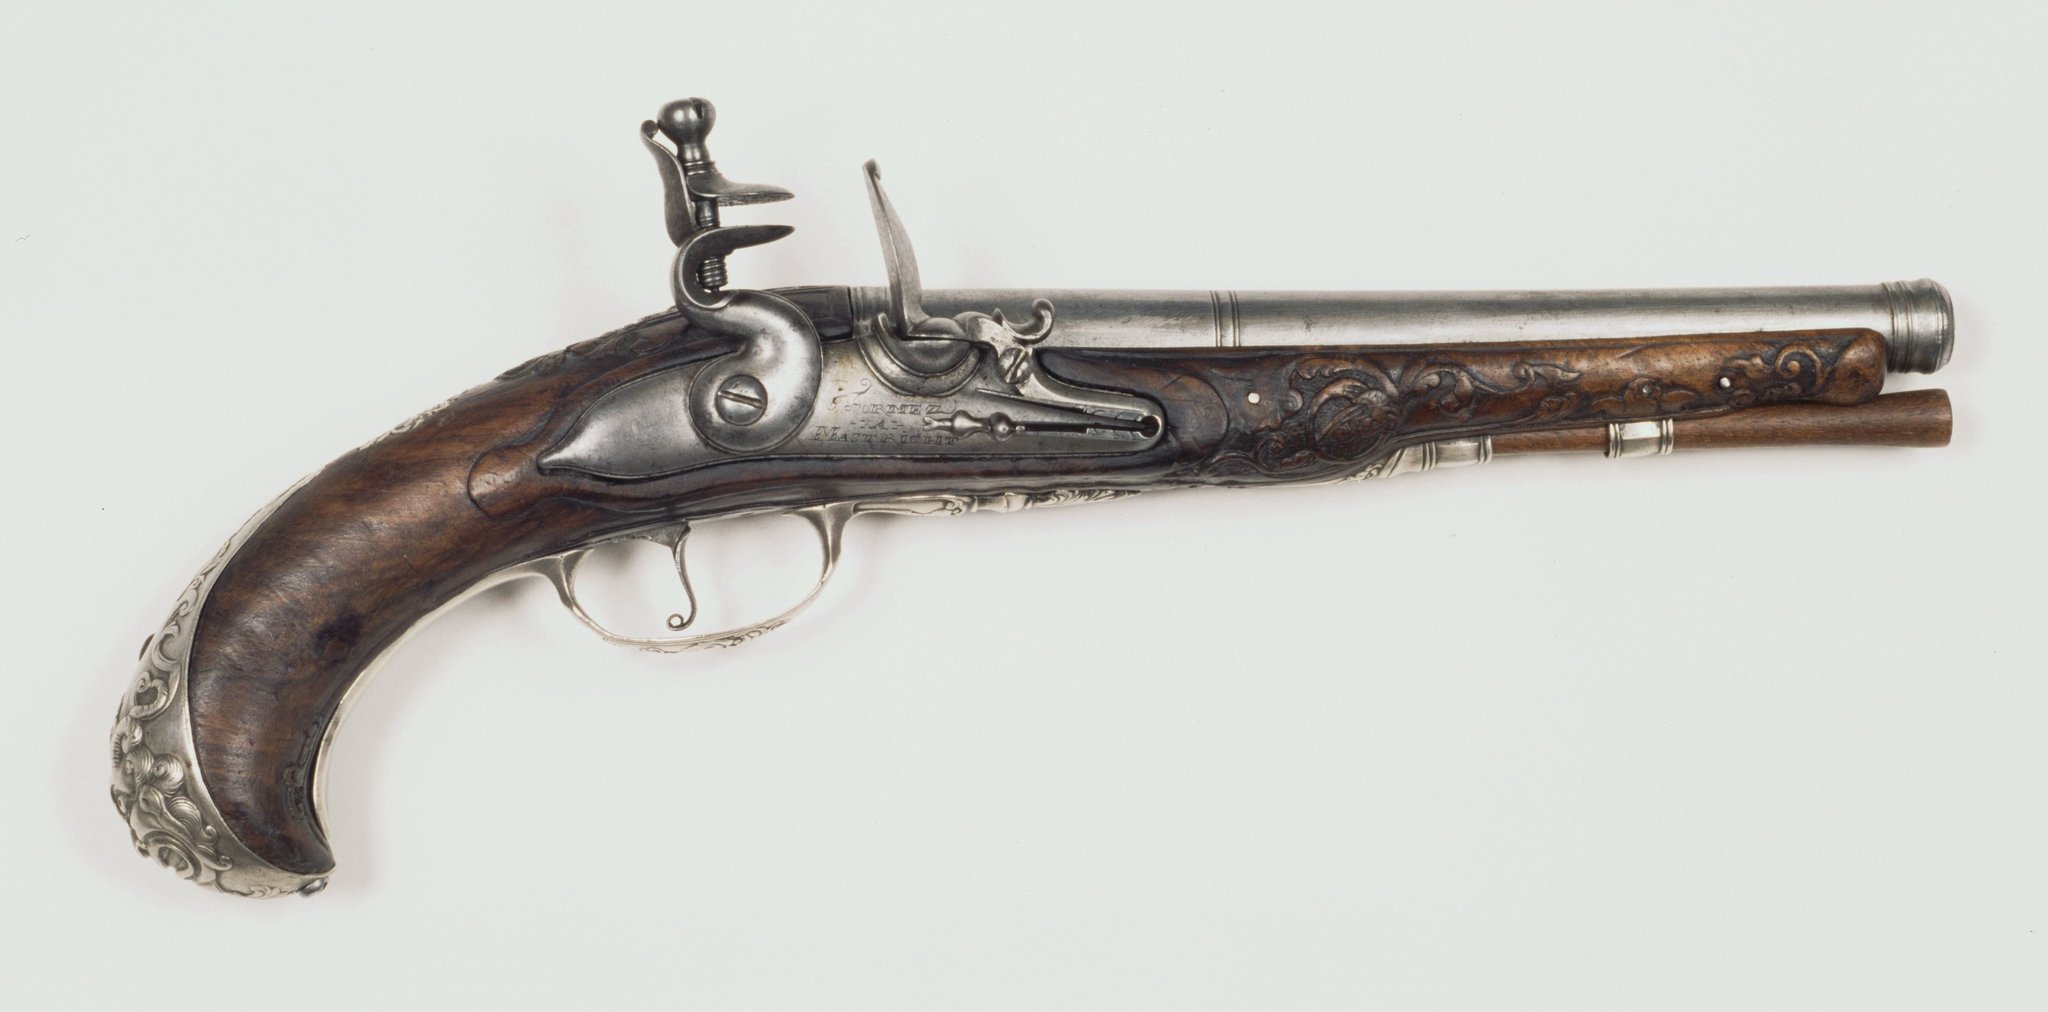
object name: flintlock pistol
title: Vuursteenpistool met batterijslot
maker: Anonymous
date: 1750-1800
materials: iron, silver, wood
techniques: relief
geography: maastricht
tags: netherlands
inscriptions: signature: ‘FORMEZ A MASTRICHT’